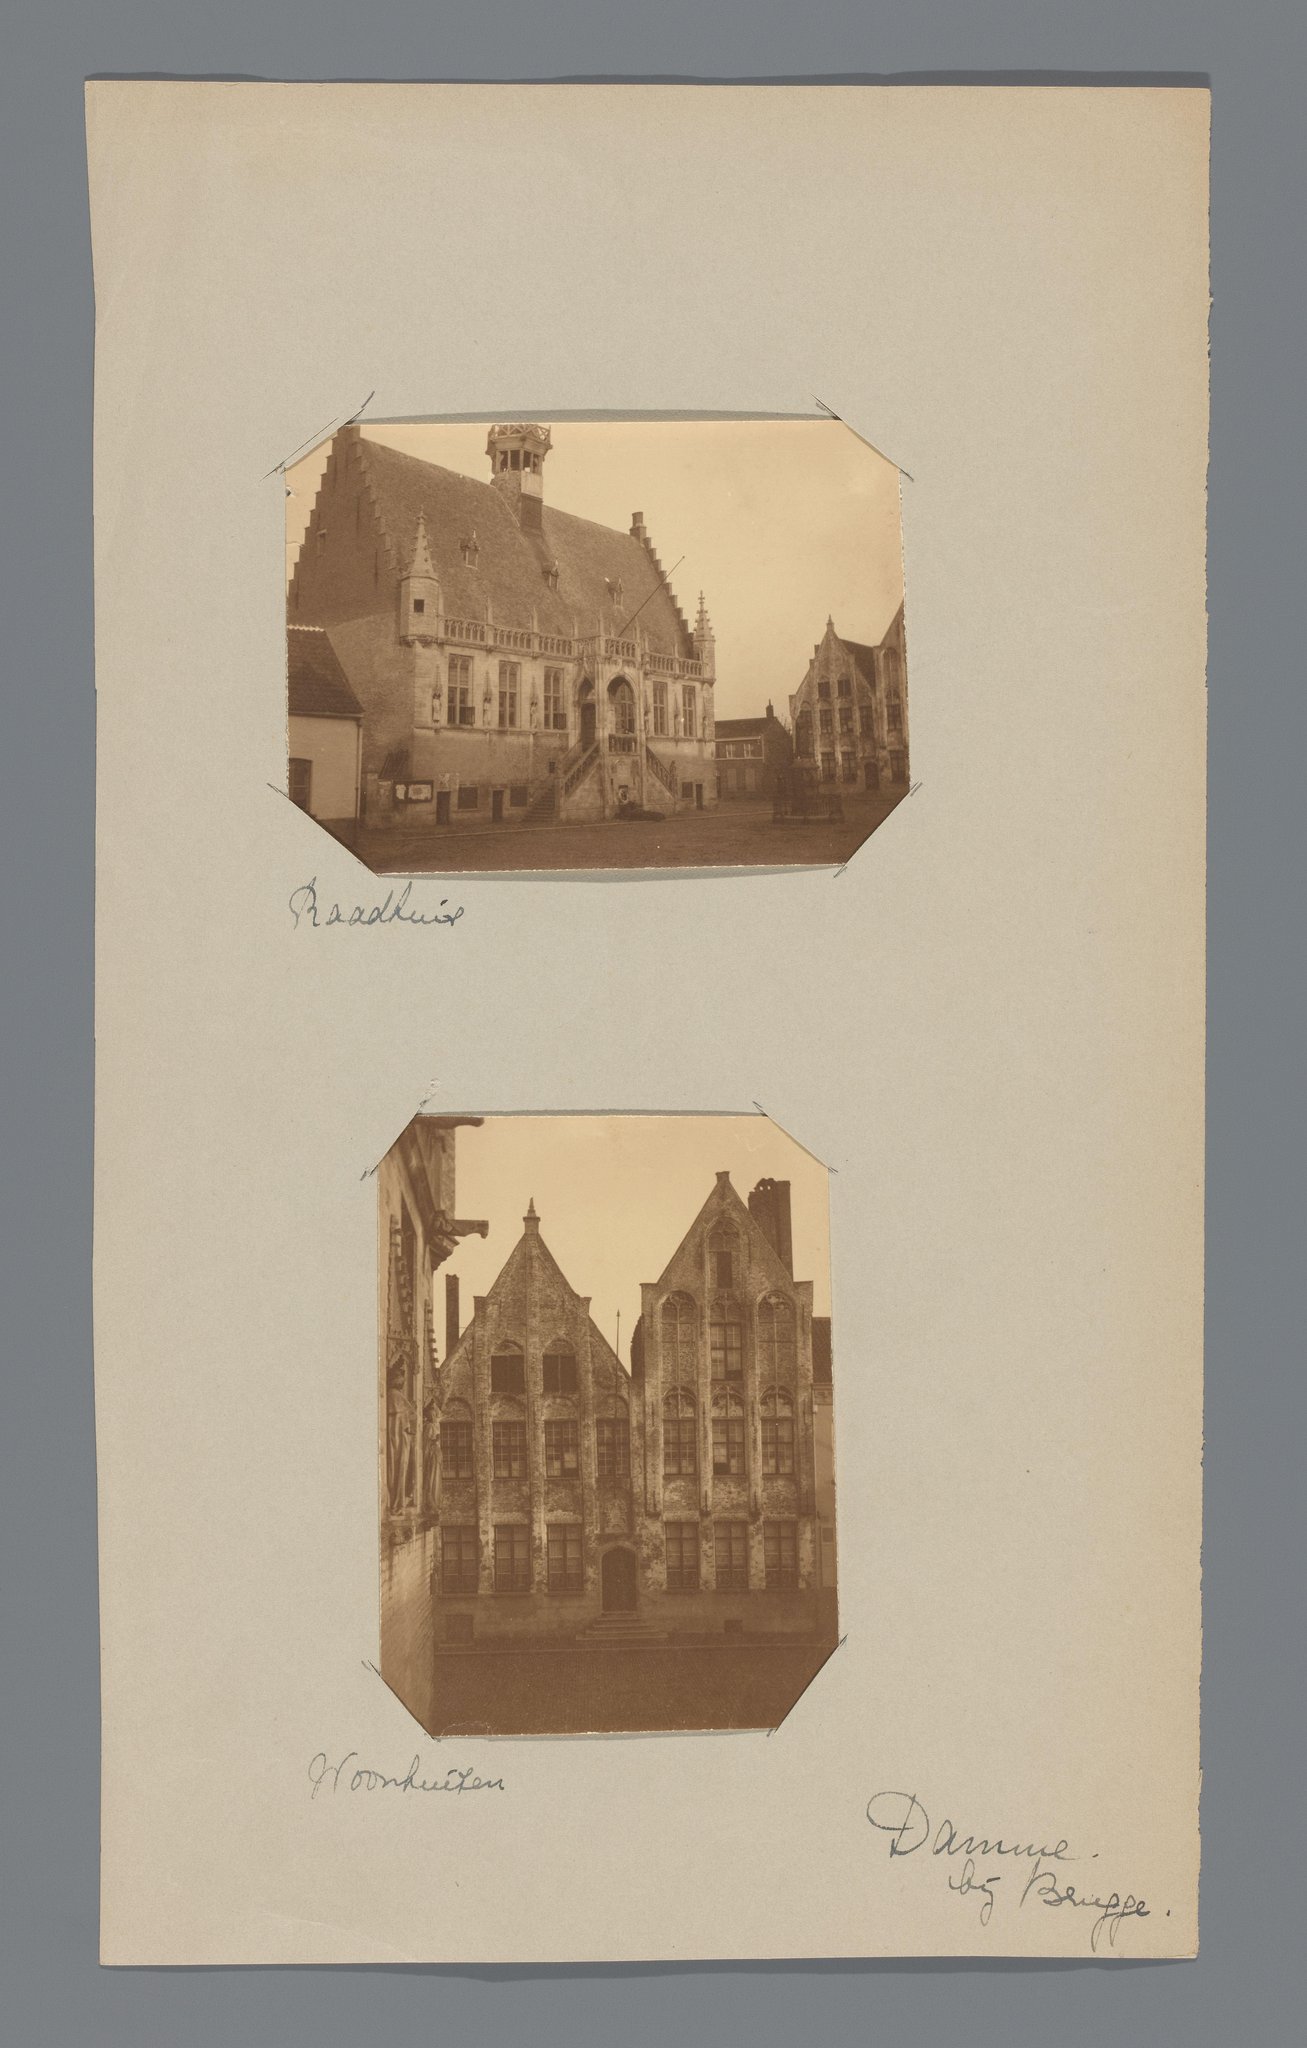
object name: photograph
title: Damme bij Brugge. Belgie. Raadhuis en Woonhuizen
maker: Anonymous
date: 1880-1920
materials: photographic support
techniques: gelatin silver print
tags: damme